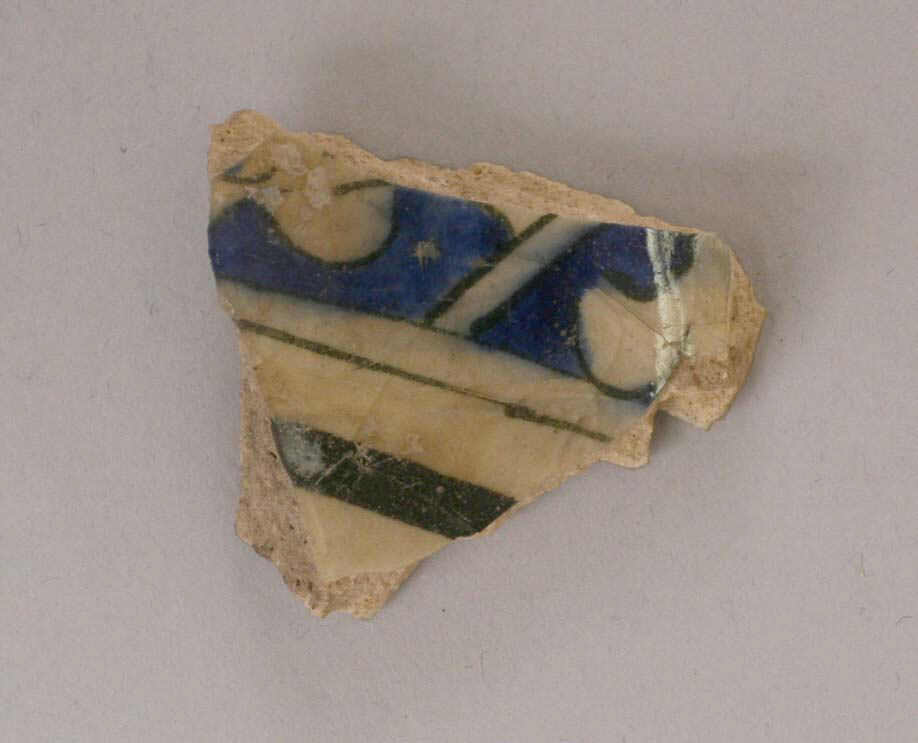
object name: fragment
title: Ceramic Fragment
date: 1301-1400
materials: glaze, stonepaste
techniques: underglaze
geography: syria